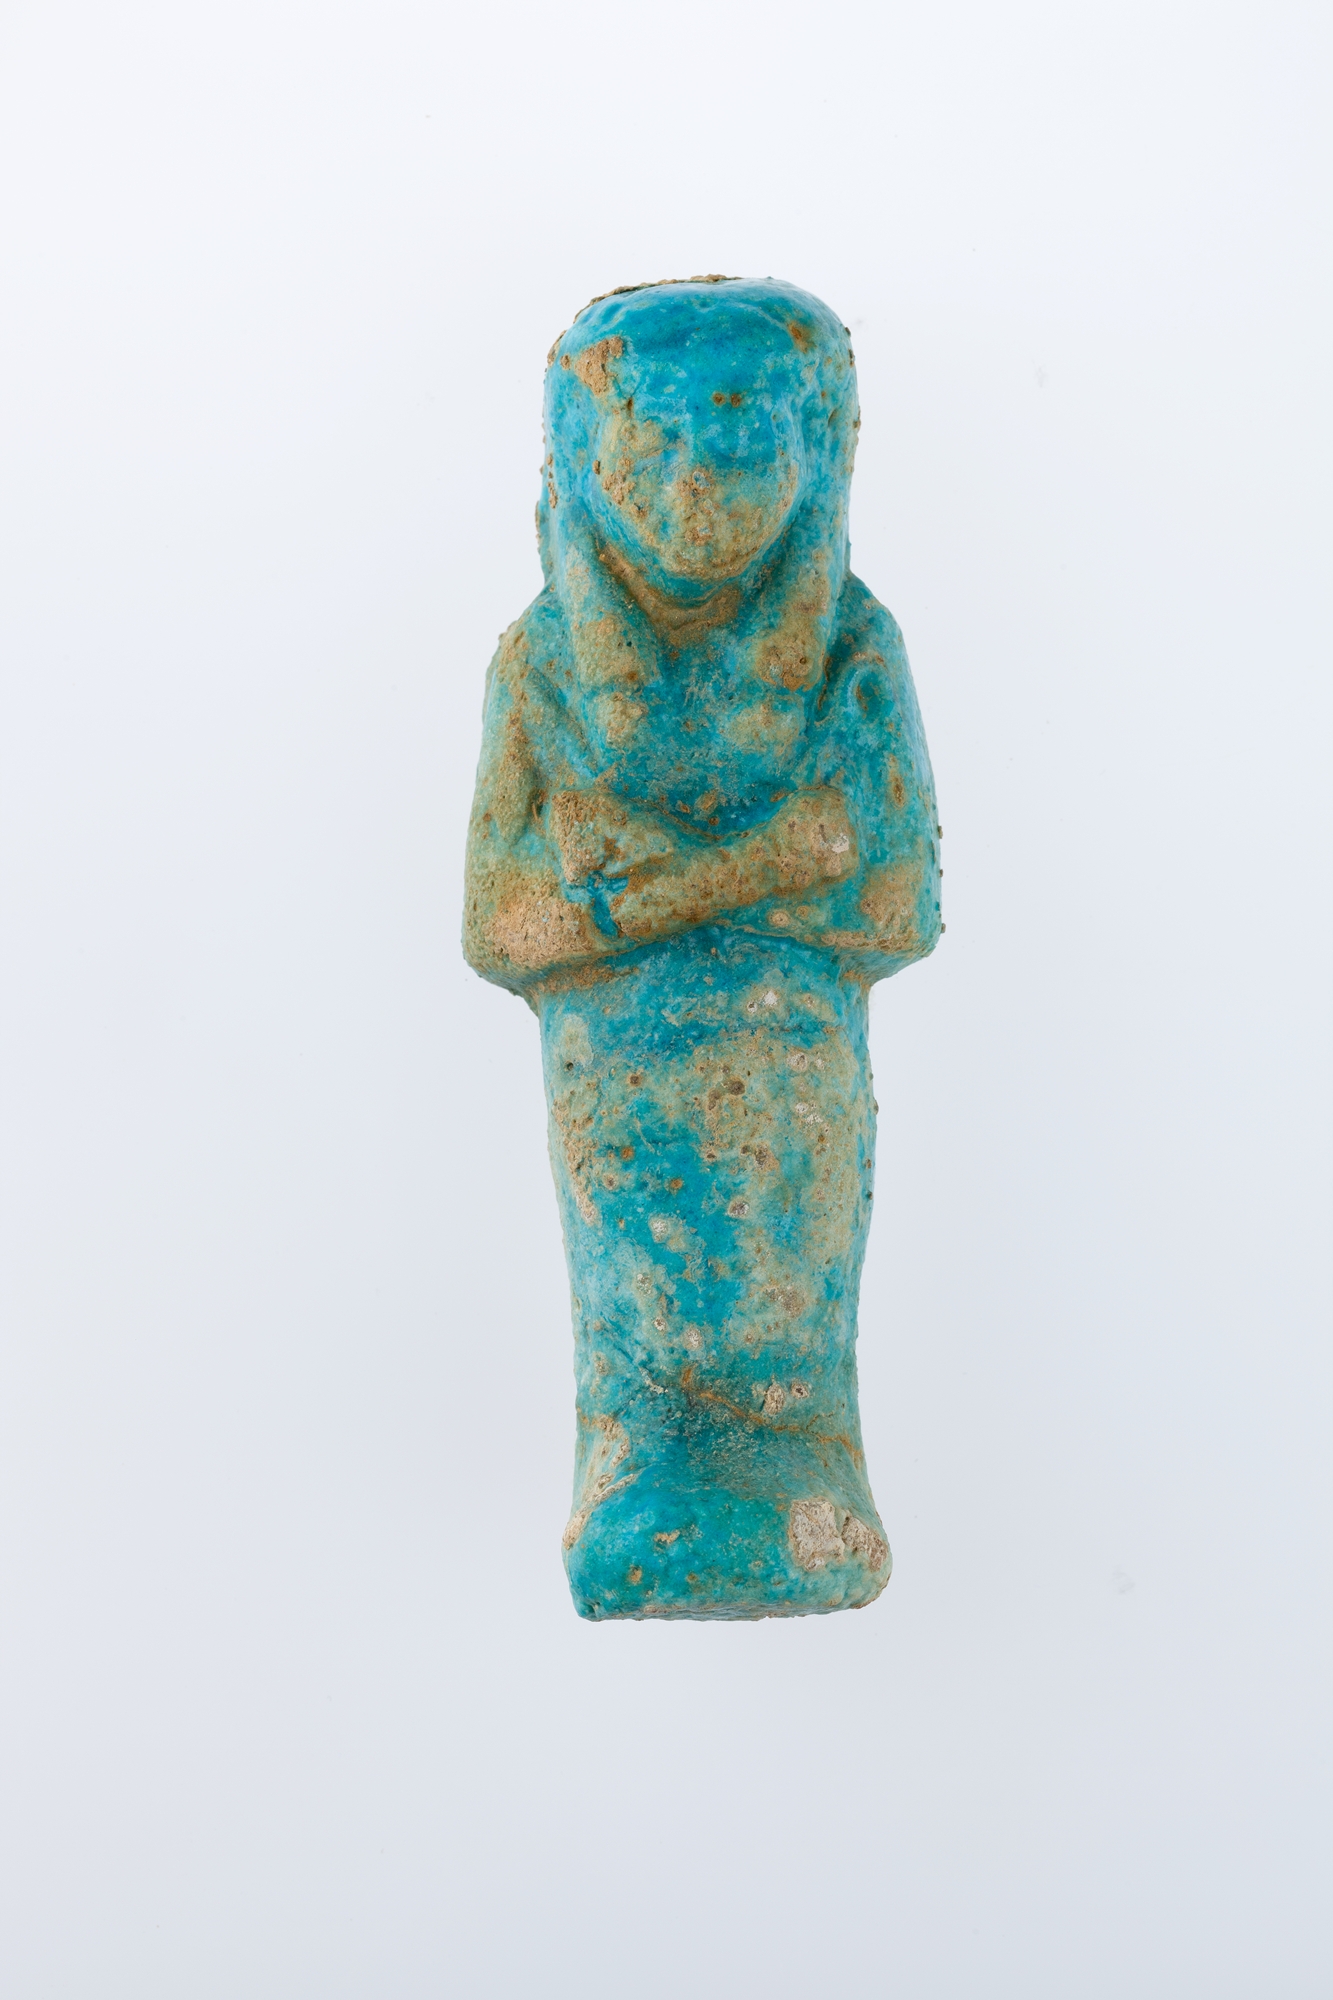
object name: shabti, henettawy c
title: Worker Shabti of Henettawy (C), Daughter of Isetemkheb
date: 990-970 BCE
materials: faience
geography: egypt